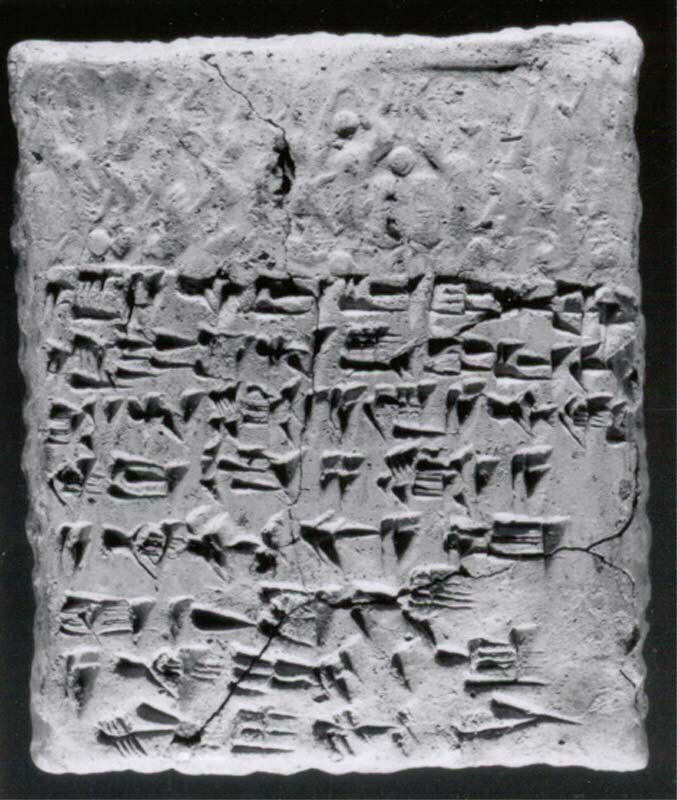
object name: cuneiform tablet case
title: Cuneiform tablet case impressed with two cylinder seals, for tablet 66.245.20a: statement before witnesses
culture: assyrian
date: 2000-1801 BCE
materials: clay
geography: anatolia